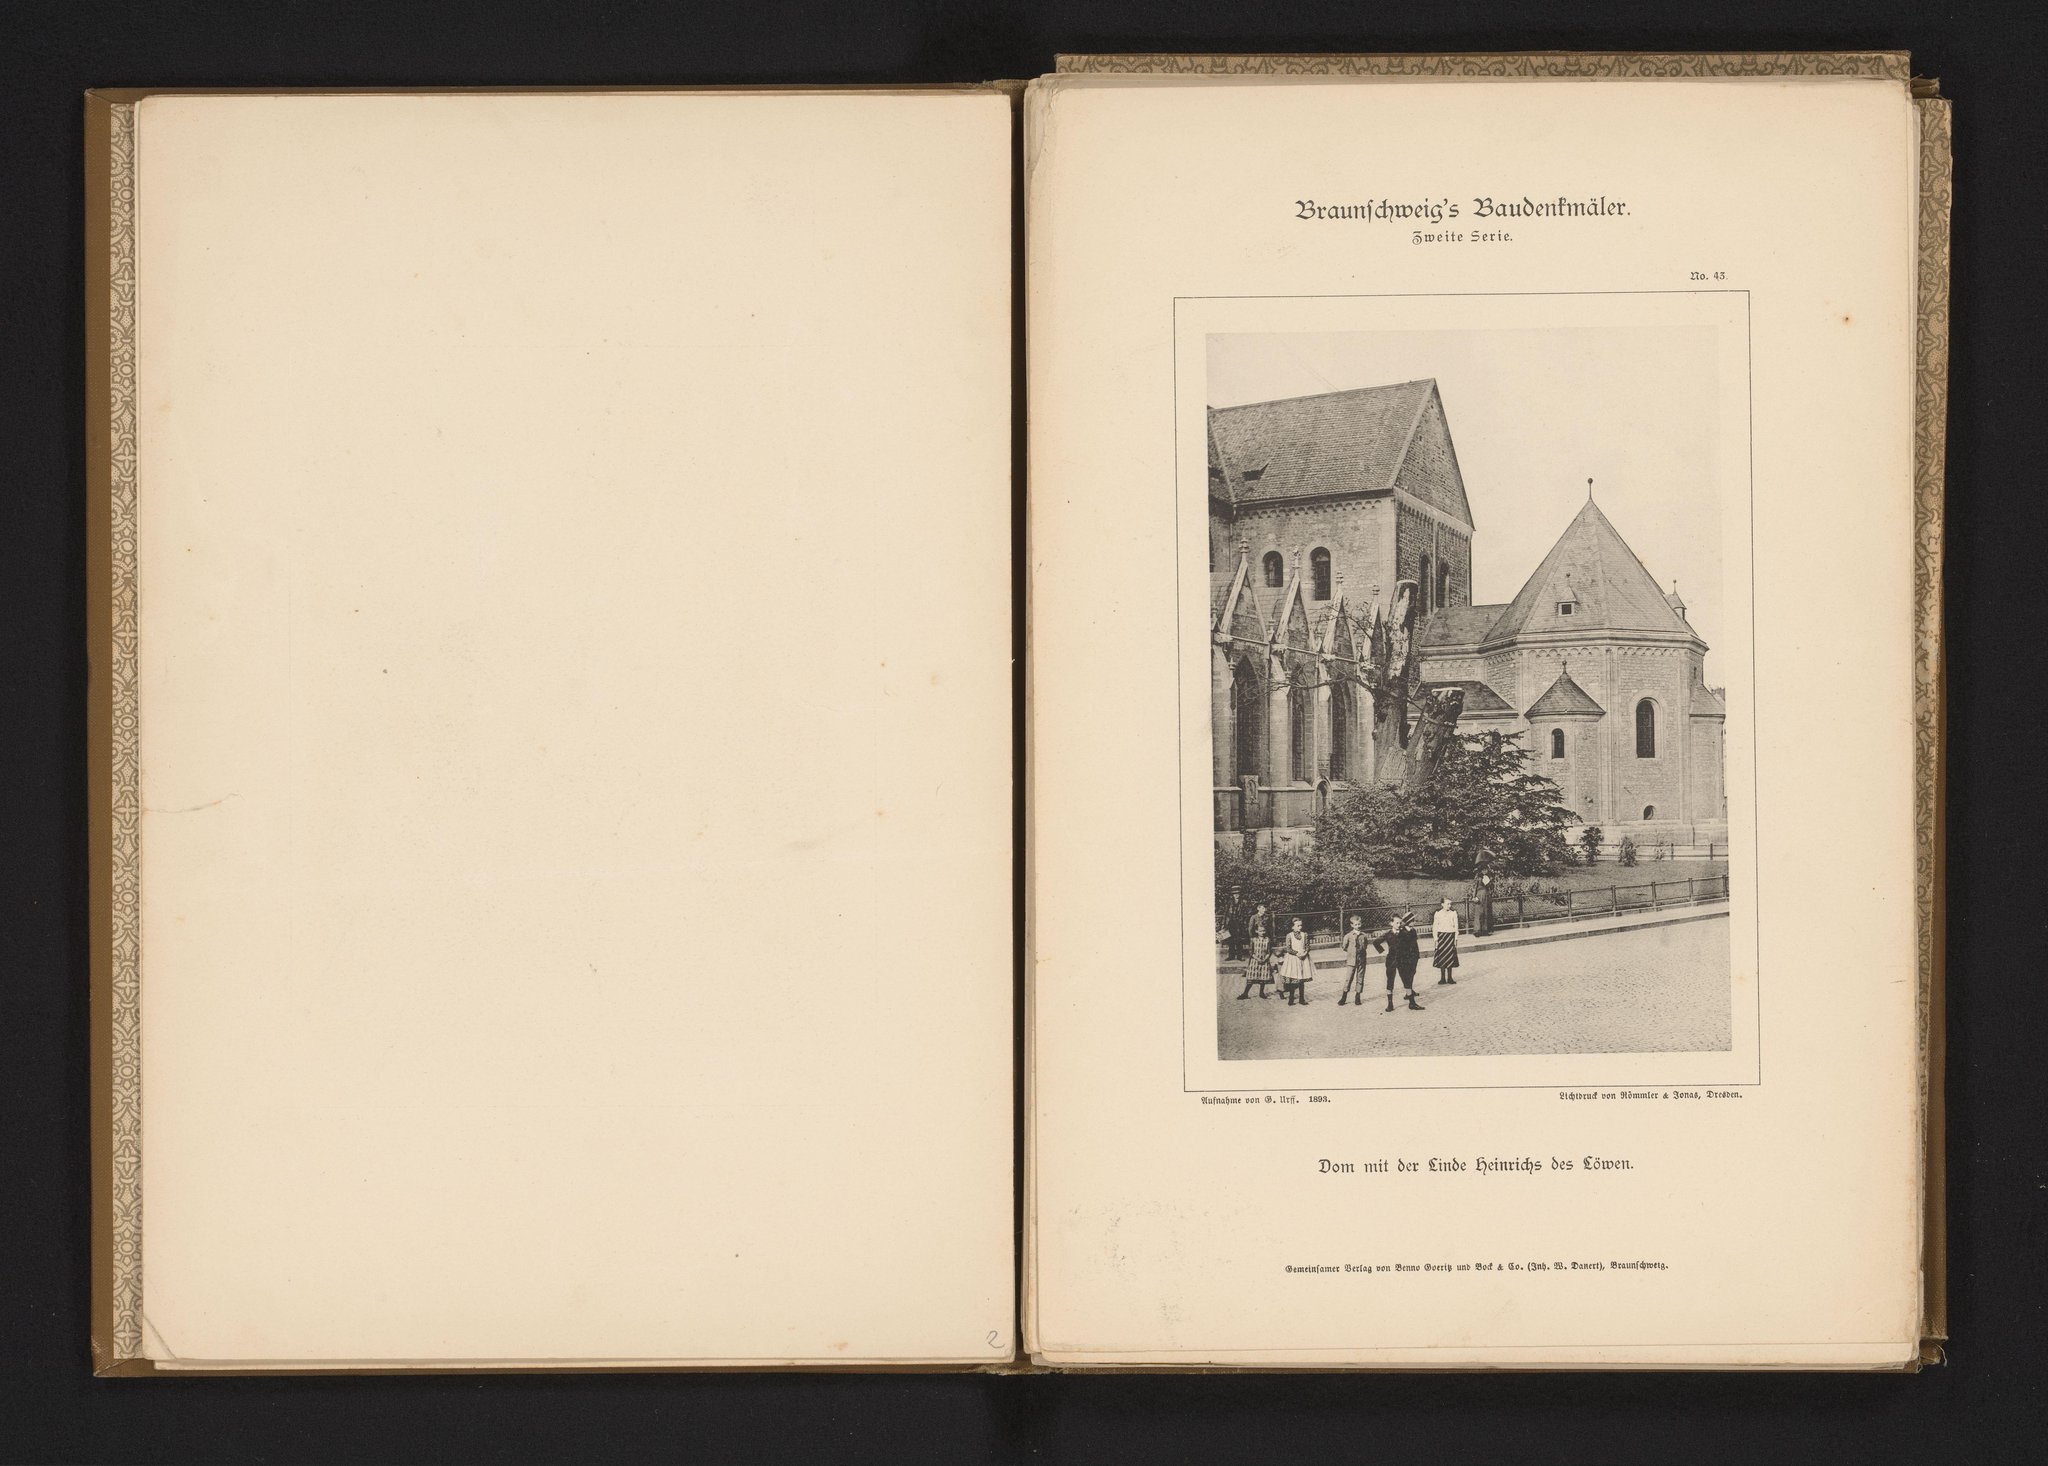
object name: page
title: Exterieur van de Dom van Braunschweig, met op de voorgrond de Heinrichslinde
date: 1893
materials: paper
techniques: photograph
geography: dresden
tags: trees: linden, church (exterior), façade (of house or building)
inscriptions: number: ‘No. 43.’